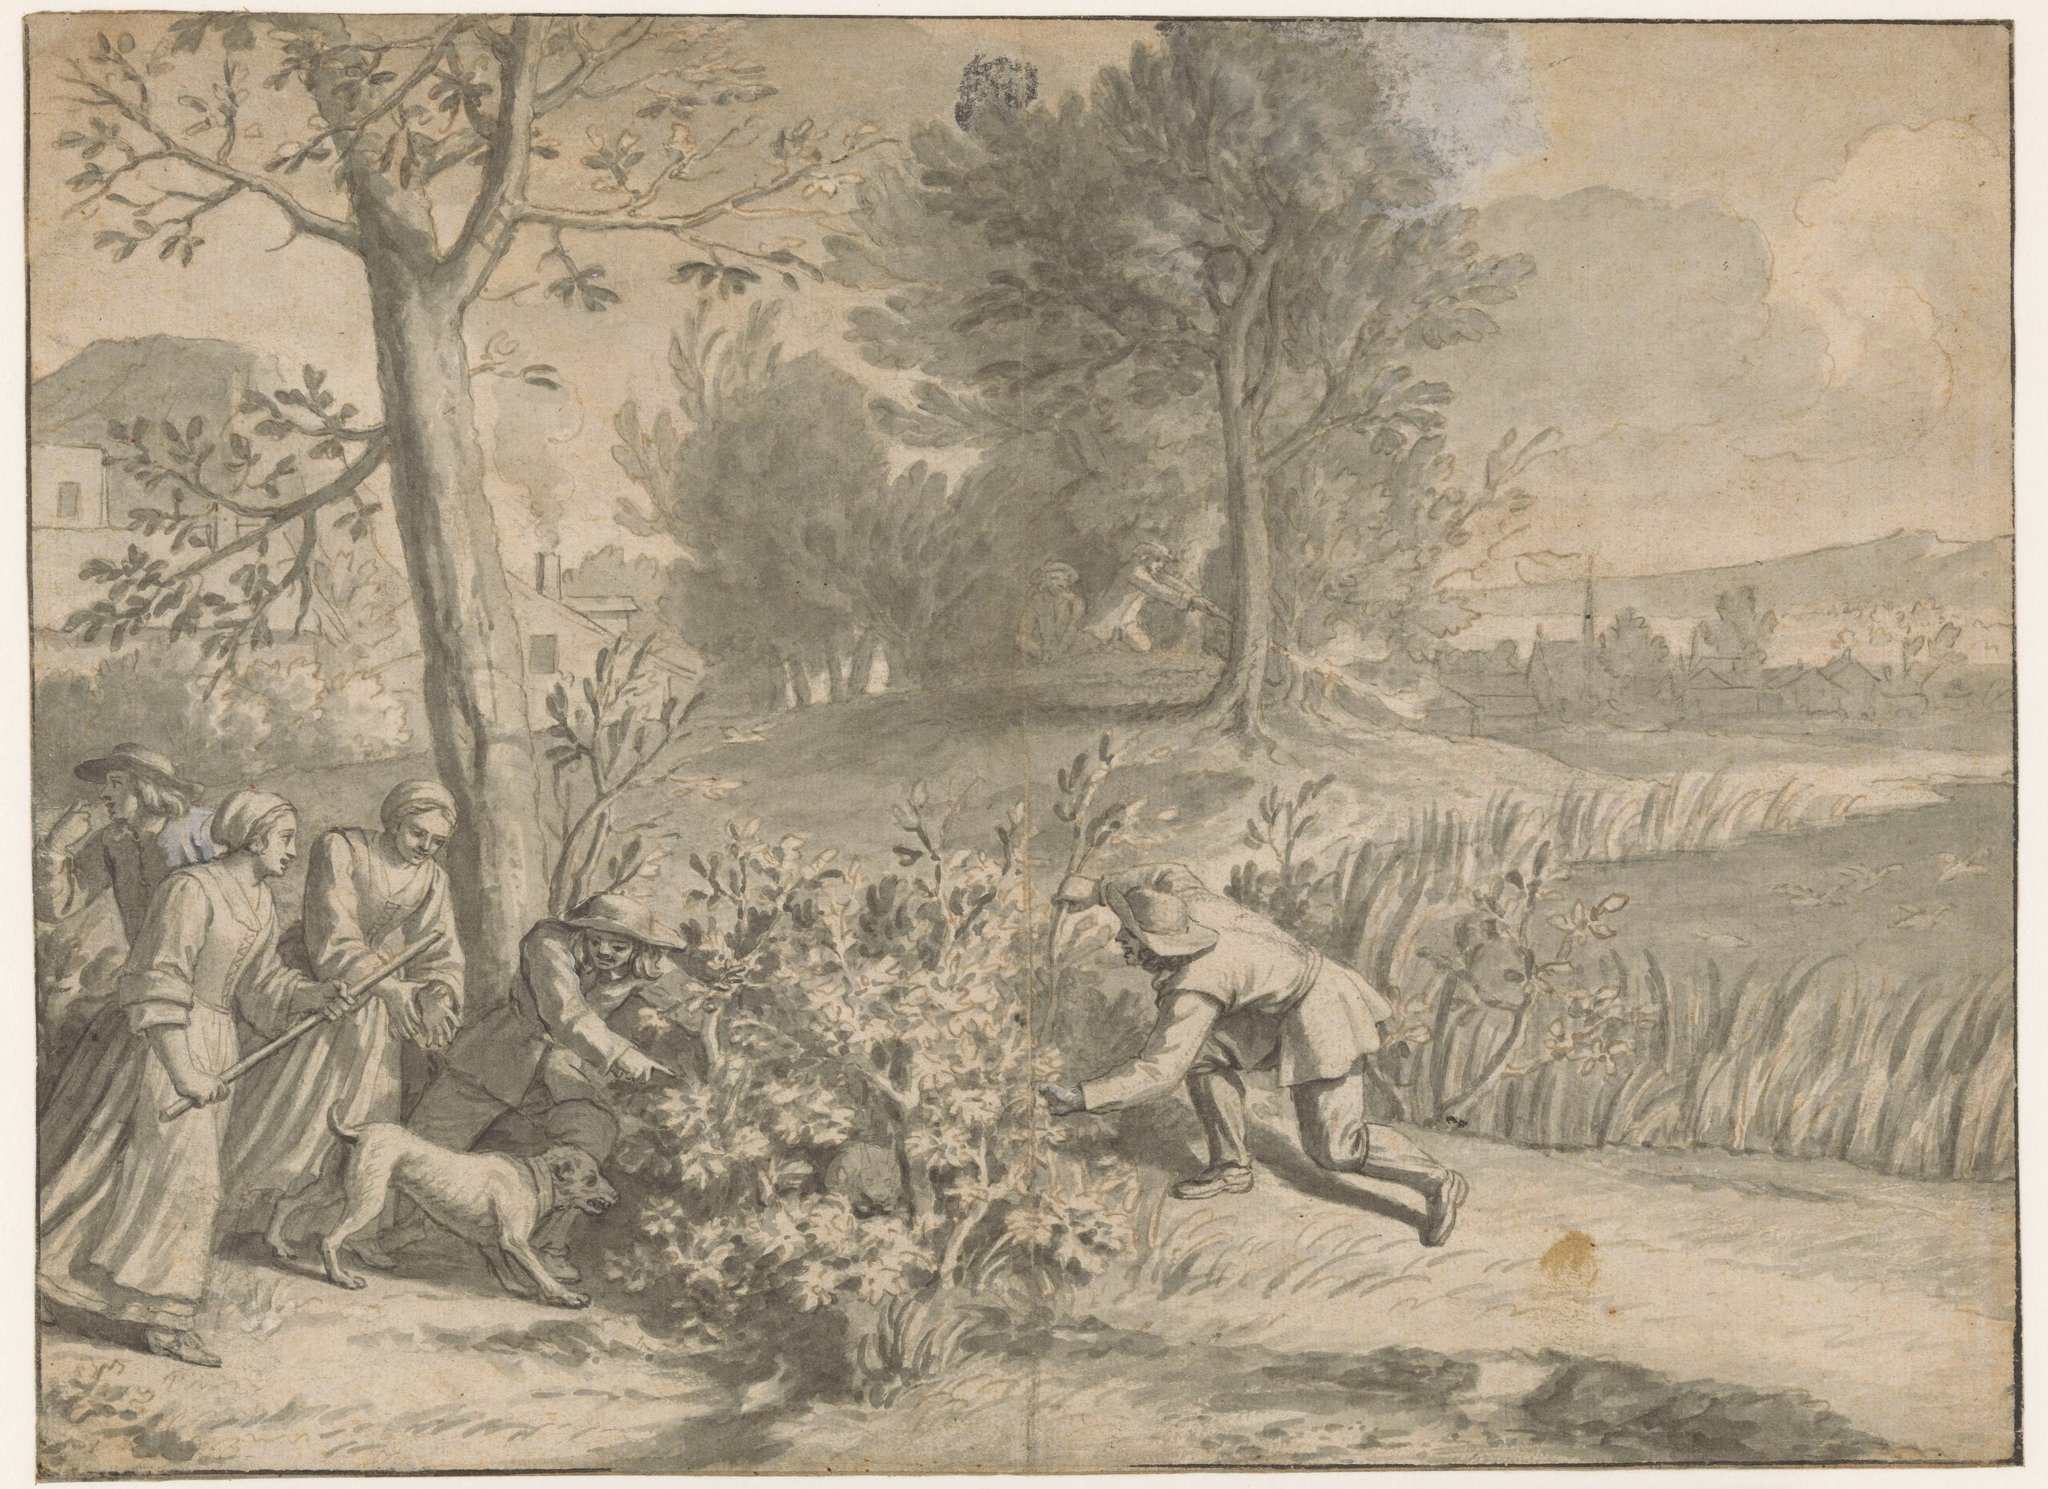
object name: drawing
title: Konijnen- en eendenjacht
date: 1596-1653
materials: chalk, ink, paper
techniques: brush, pen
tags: hare-hunting, rabbit-hunting, bird hunting, water-birds